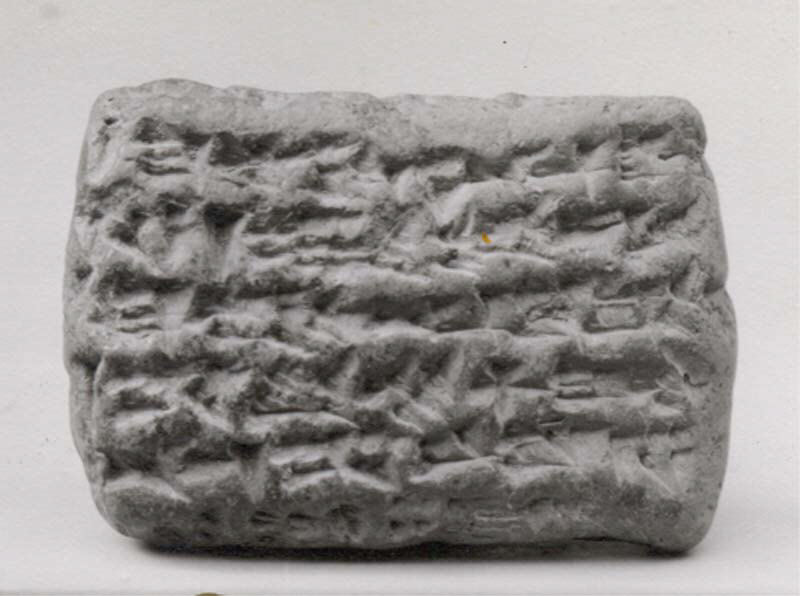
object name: cuneiform tablet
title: Cuneiform tablet: account of silver disbursements, Egibi archive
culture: babylonian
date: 601 BCE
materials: clay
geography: mesopotamia